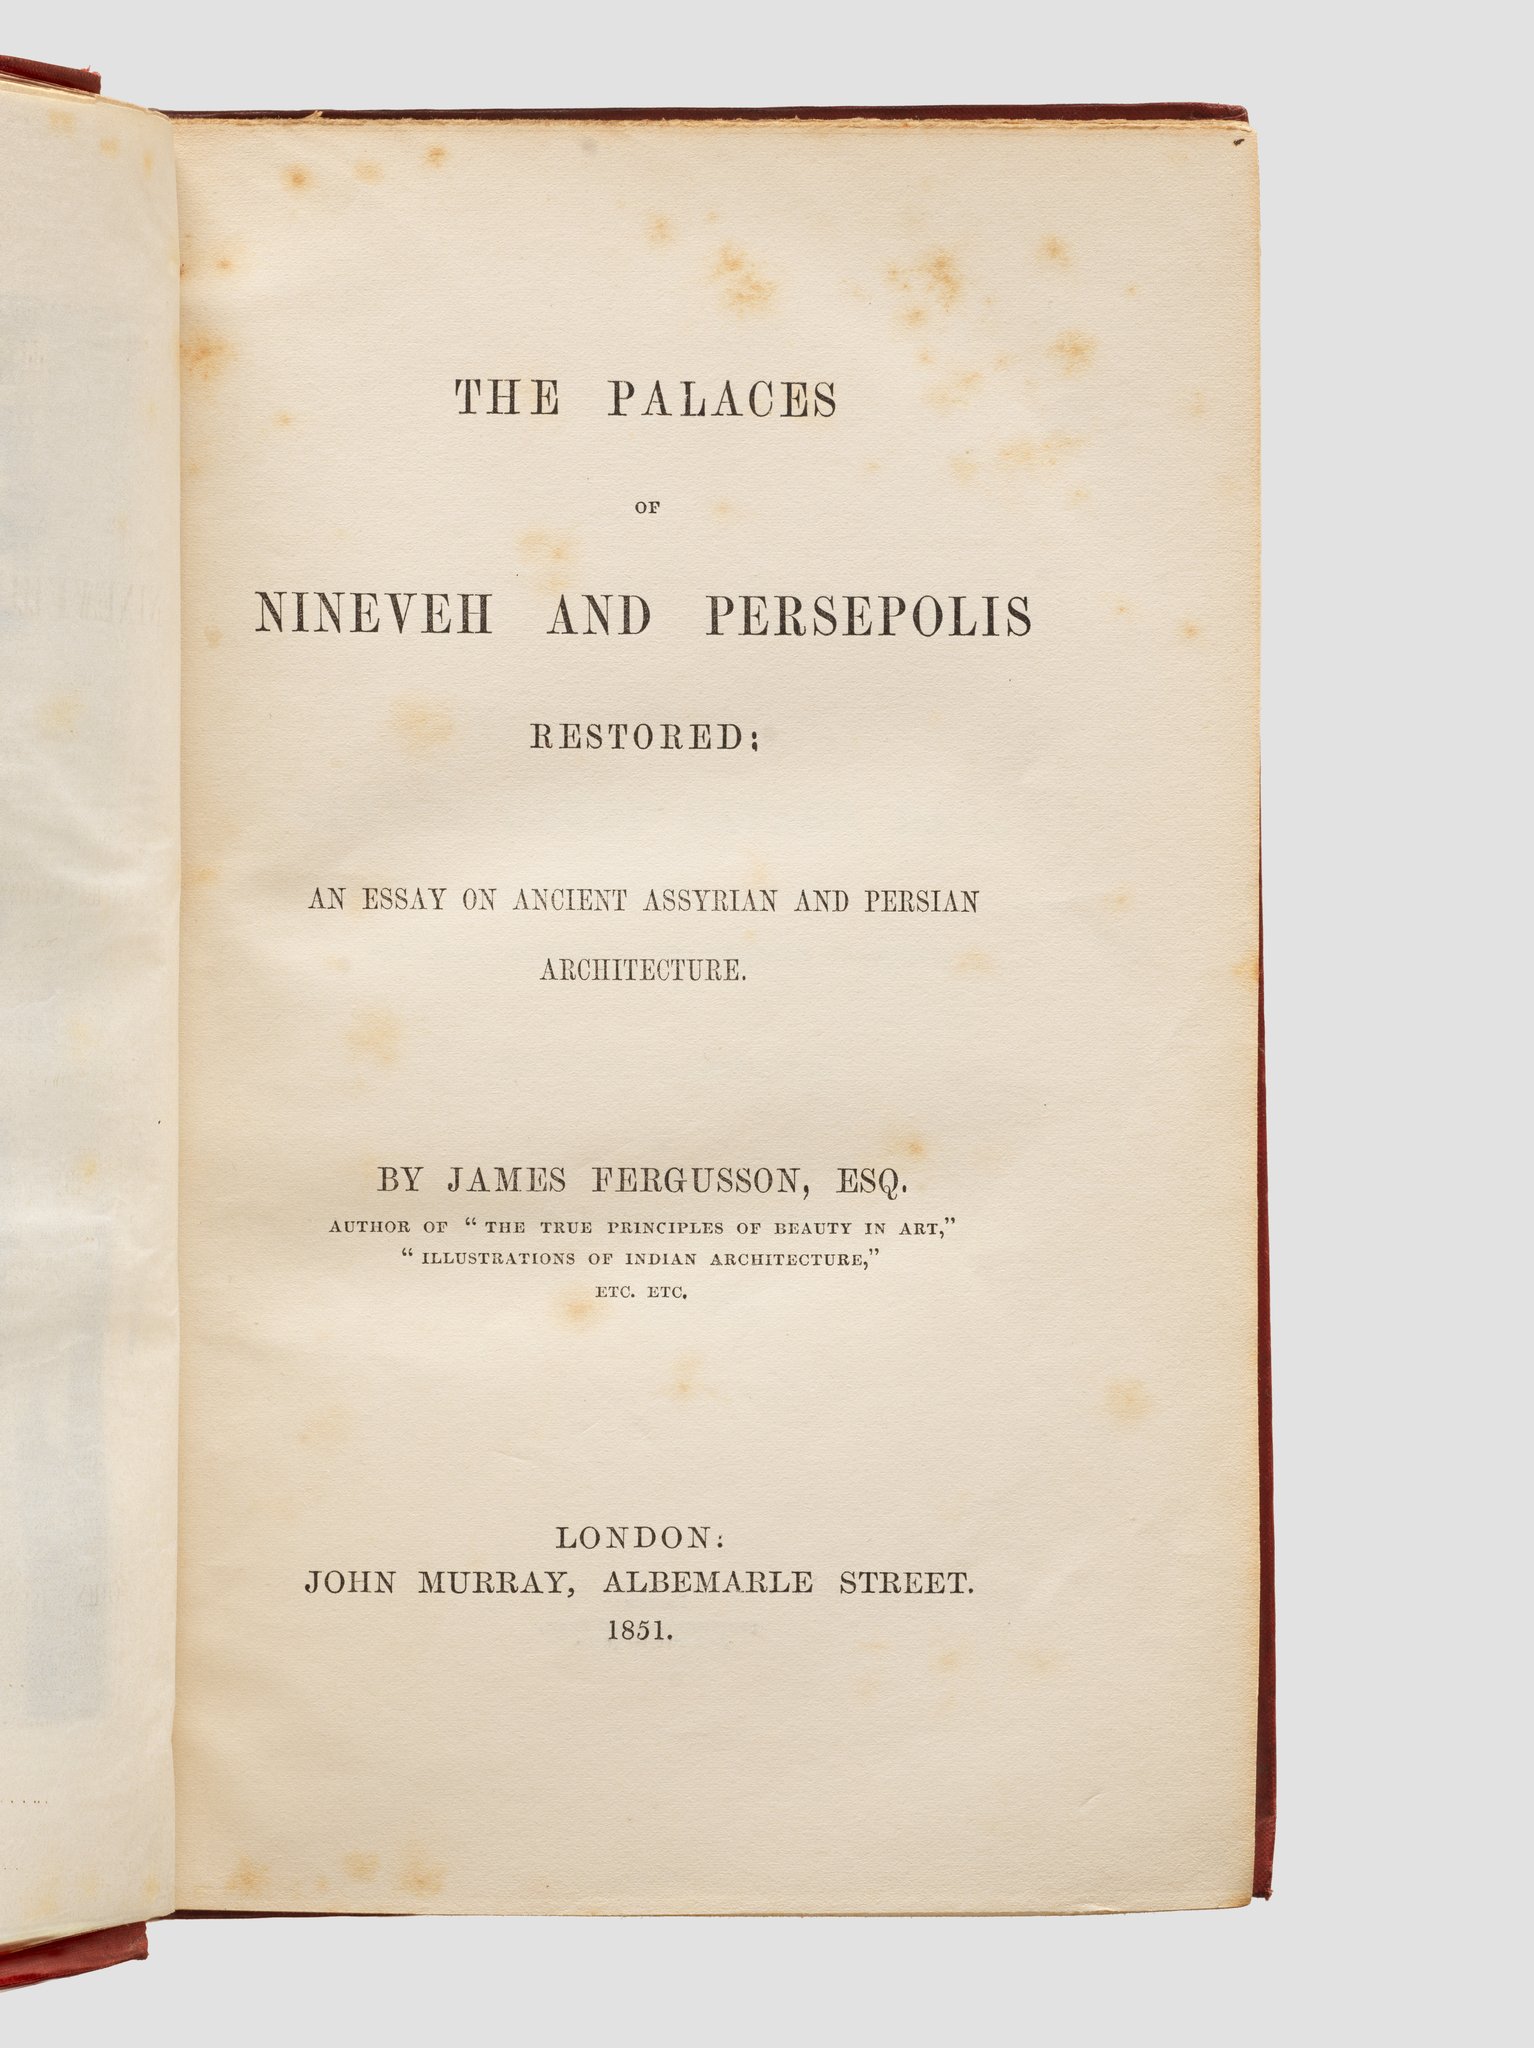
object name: book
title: The Palaces of Nineveh and Persepolis Restored: An Essay on Ancient Assyrian and Persian Architecture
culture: british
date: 1851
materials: board, textile, paper